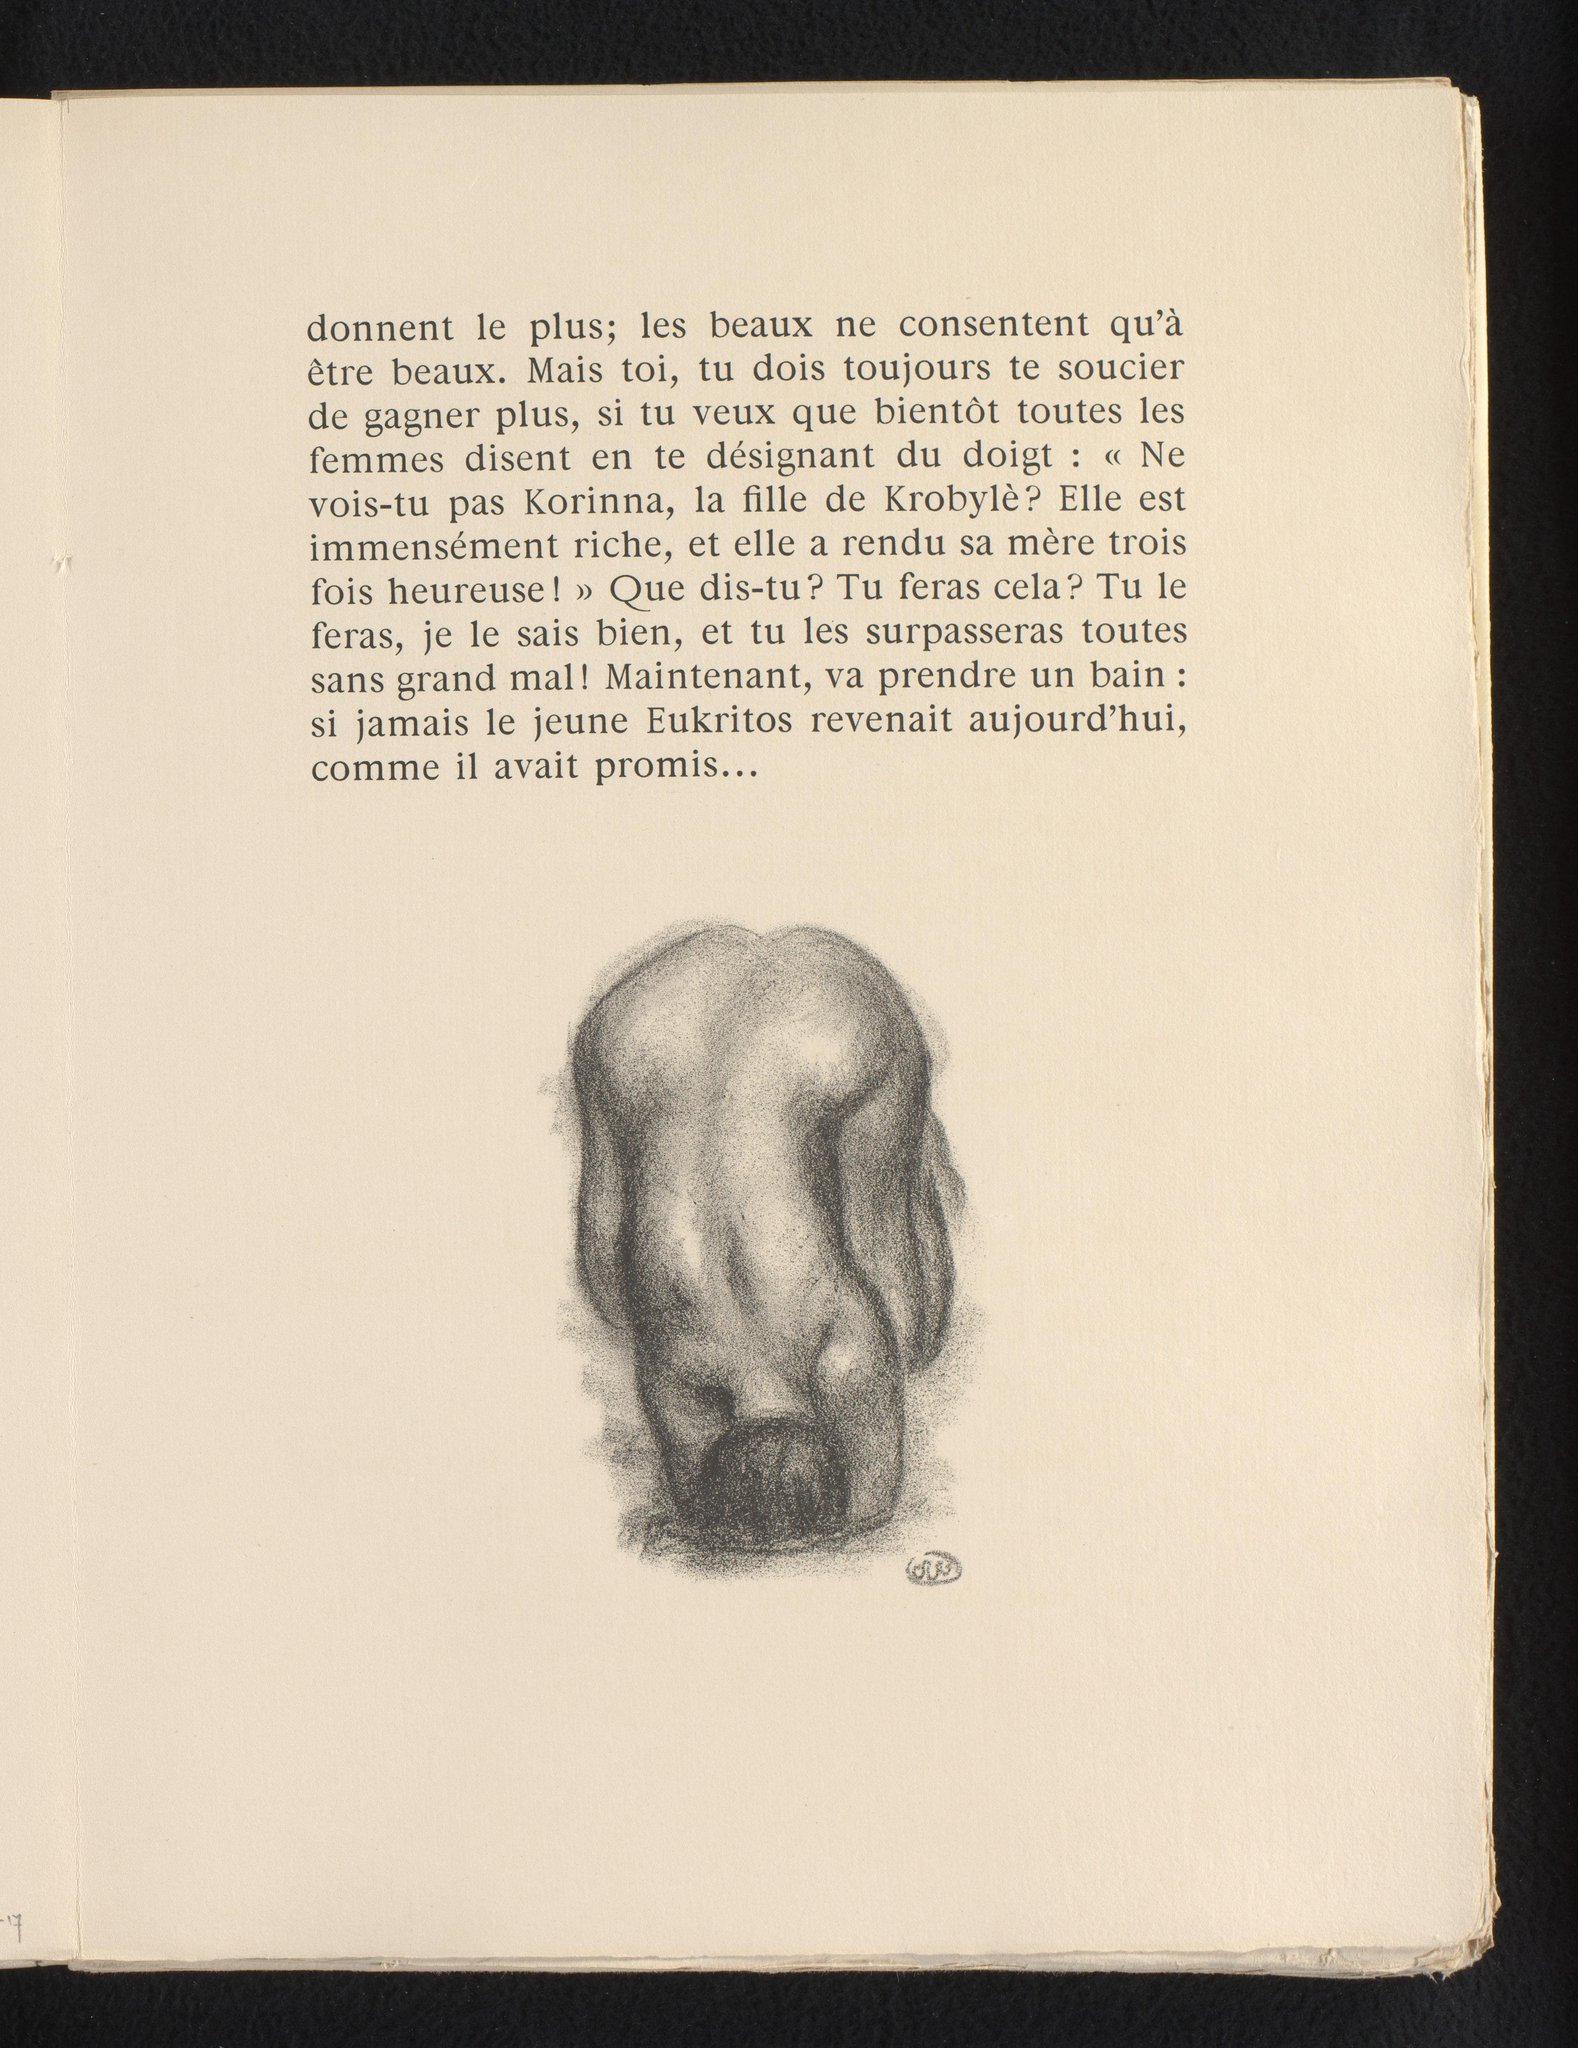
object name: print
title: Voorovergebogen knielende naakte vrouw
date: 1948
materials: paper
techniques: letterpress printing, lithograph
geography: paris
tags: huddled figure - aa - female human figure, woman (showing herself) undressed, quasi-nude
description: Prent uit: Lucianus van Samosata. Dialogues des Courtisanes. [Vertaald uit het Grieks door] Charles Astruc. Parijs: s.n., 1948, p. 37.